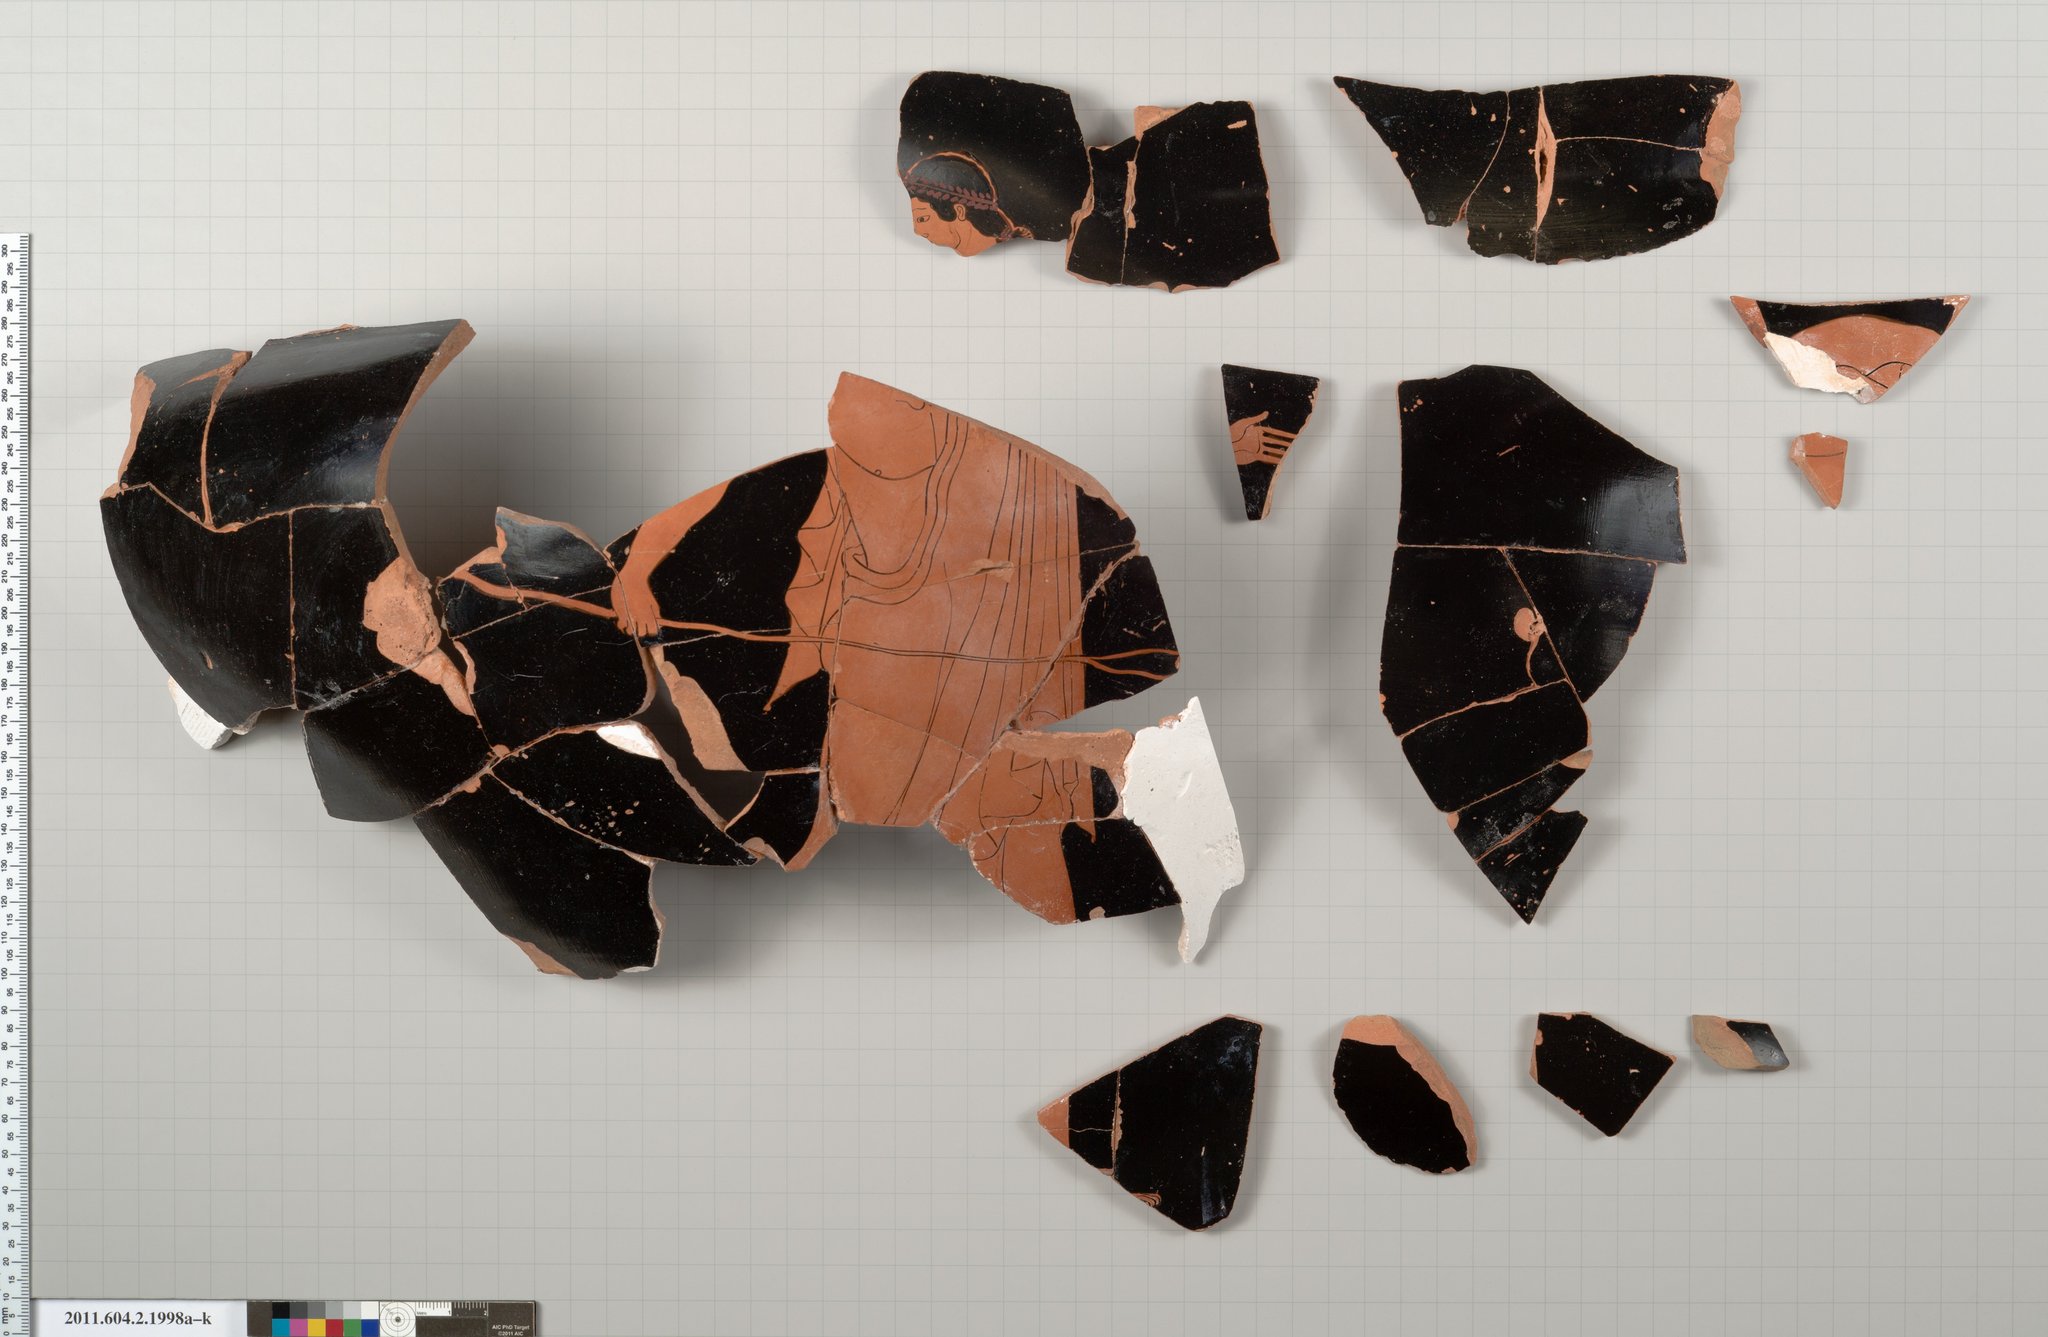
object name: amphora fragment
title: Terracotta fragments of an amphora (jar)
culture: greek, attic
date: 480-470 BCE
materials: terracotta